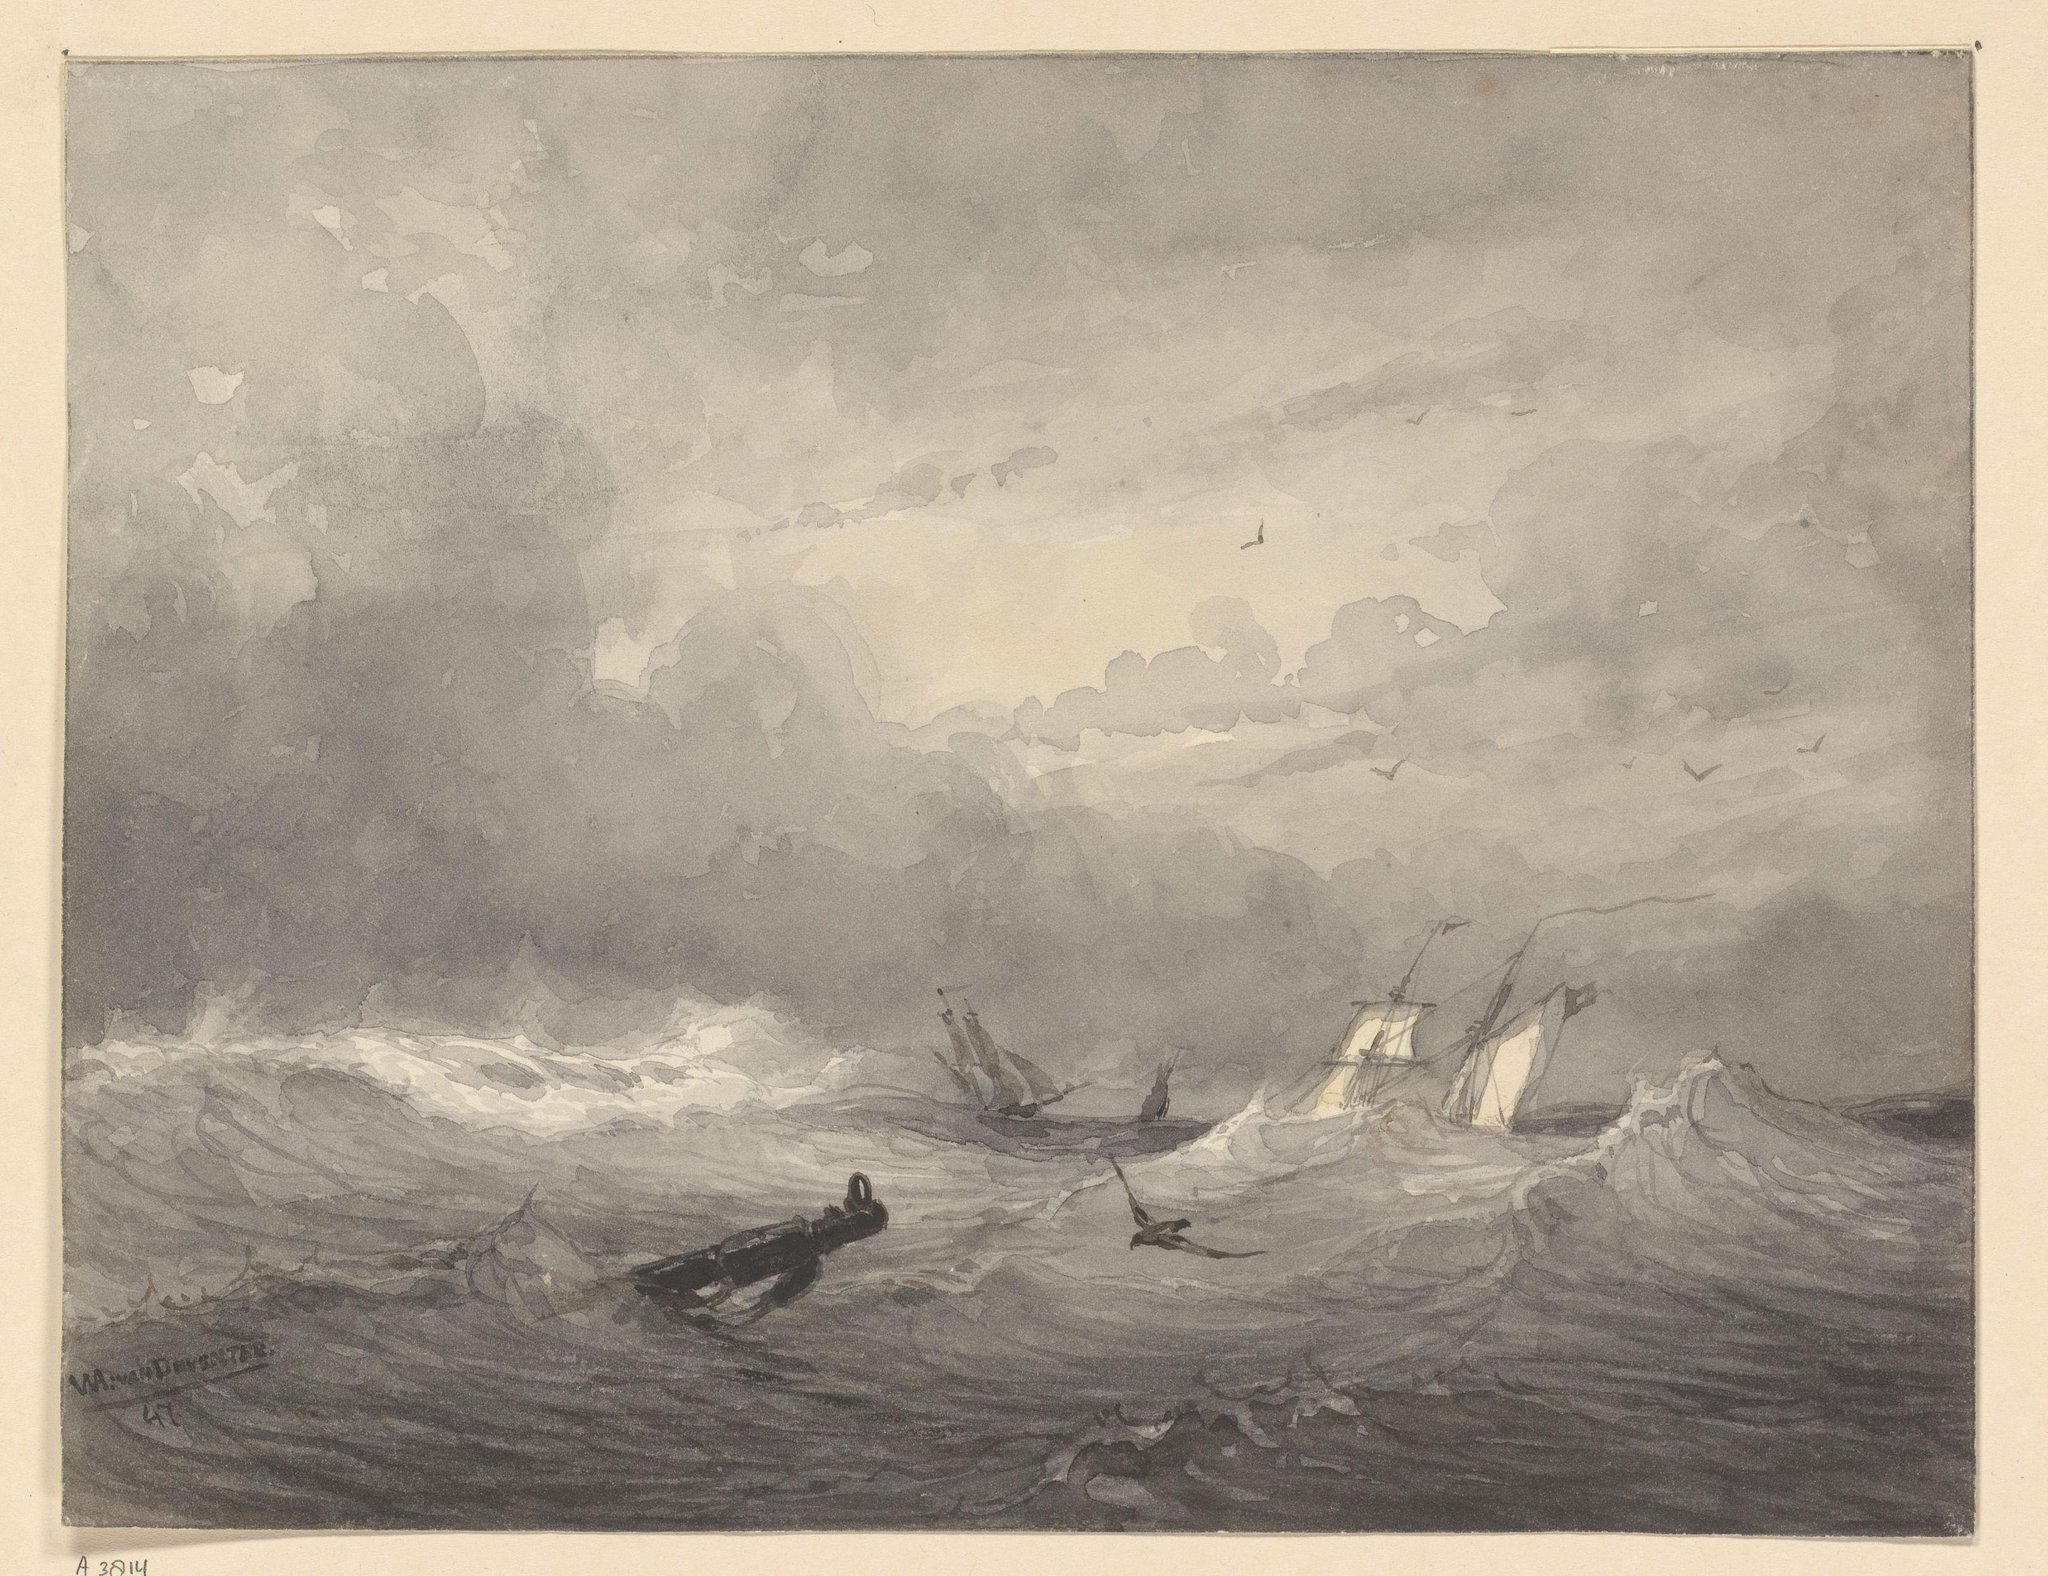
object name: drawing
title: Zeegezicht met enige schepen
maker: willem anthonie van deventer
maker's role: draughtsman, painter, print maker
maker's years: 1824-1893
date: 1847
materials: paper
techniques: brush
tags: sea (seascape)